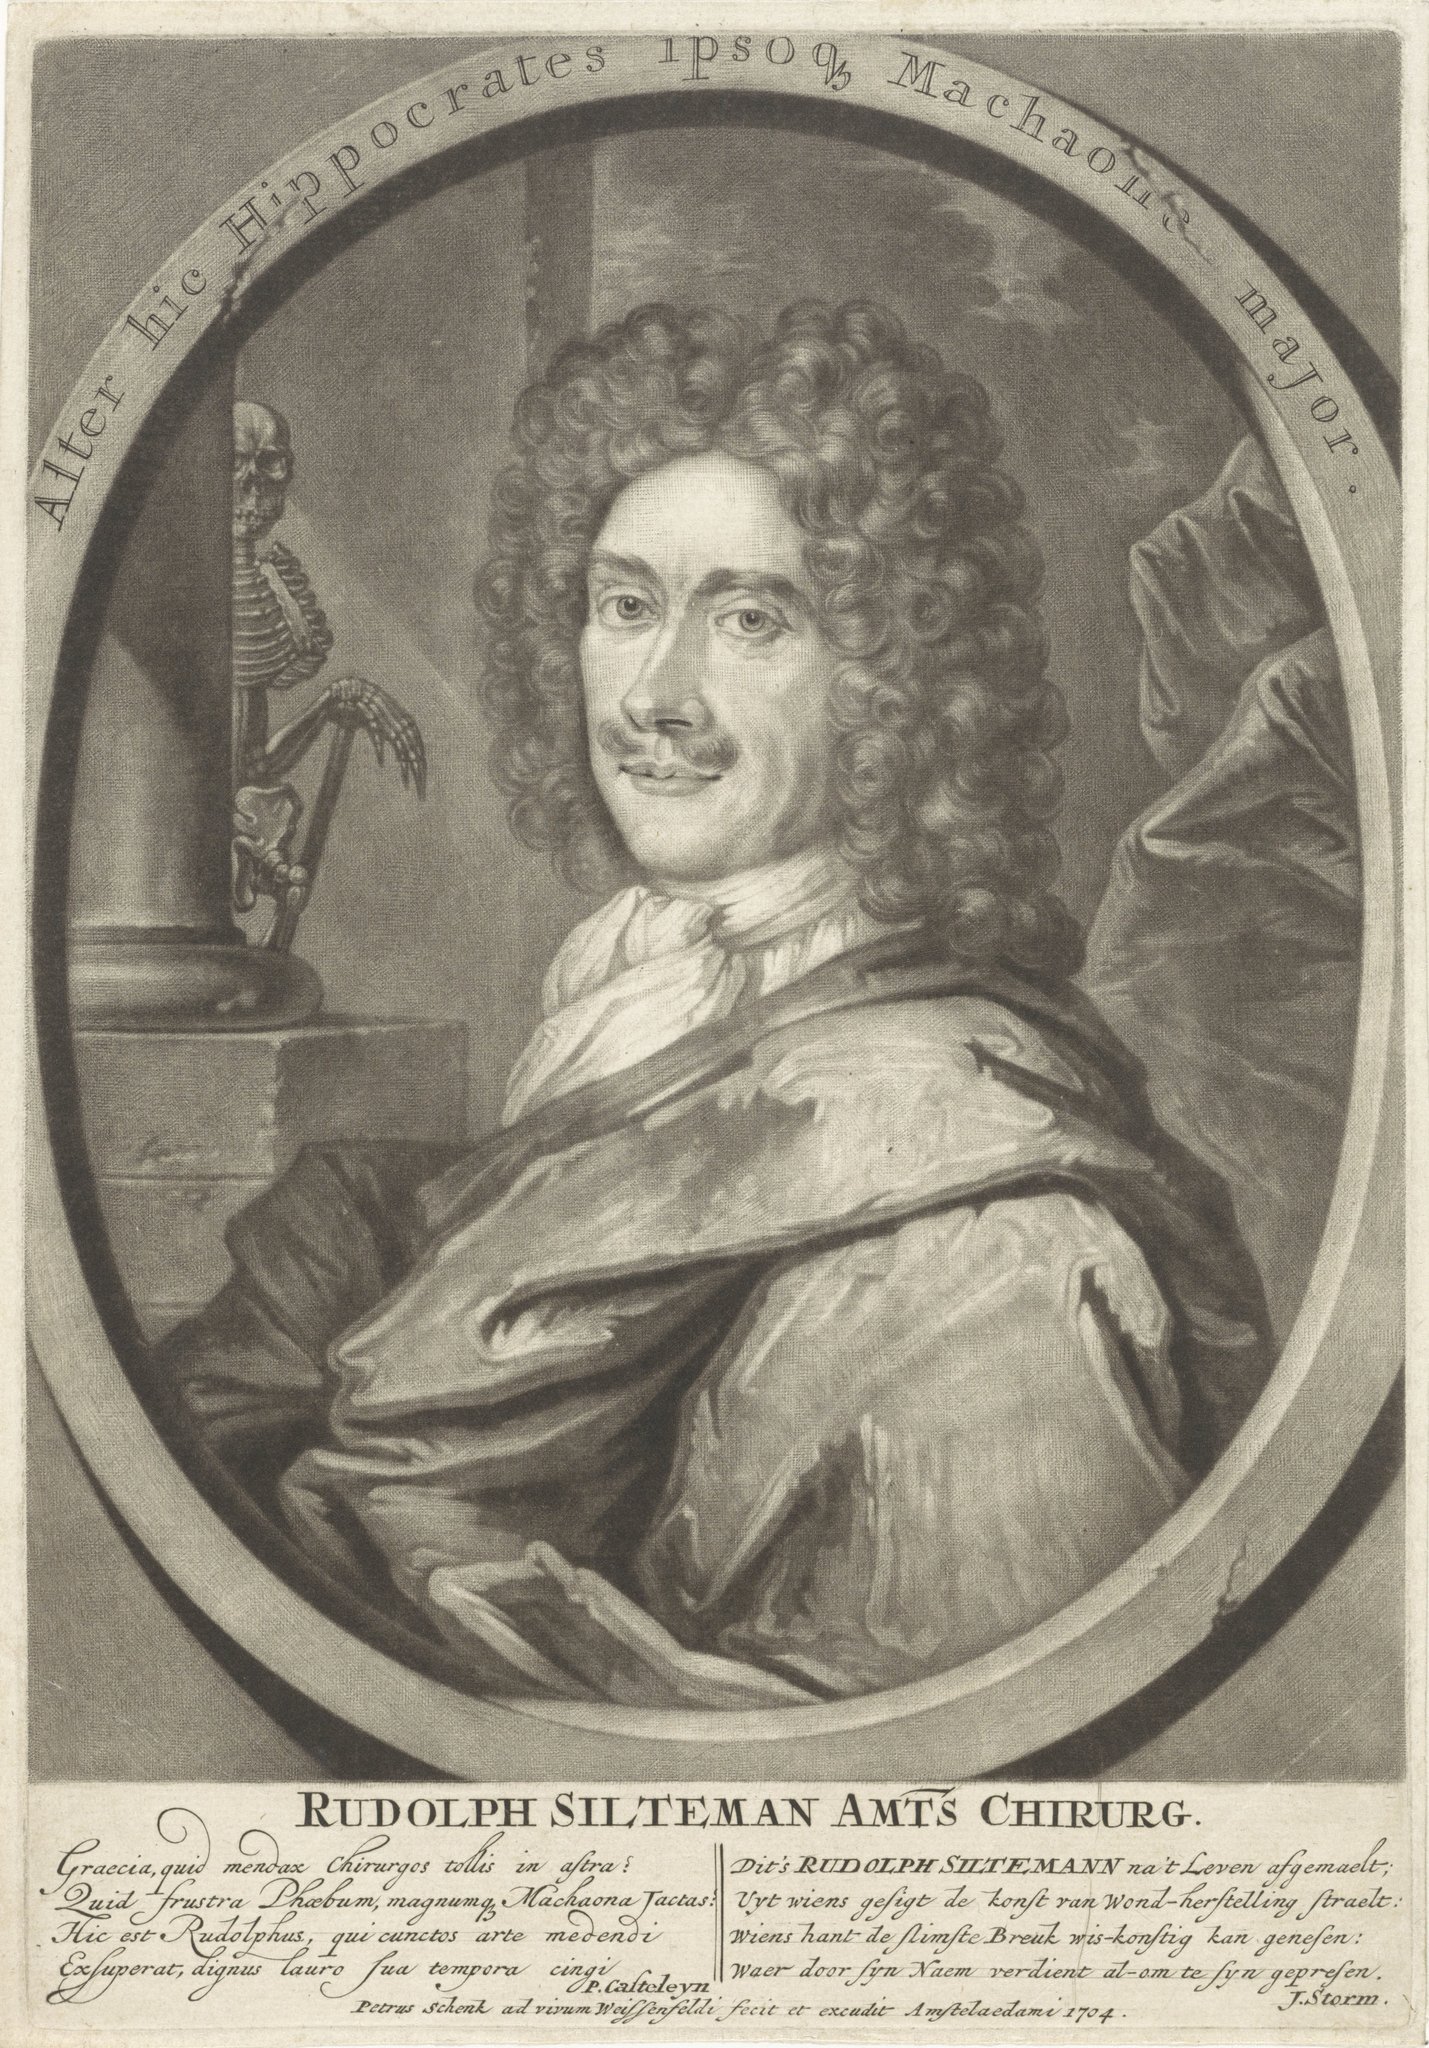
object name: print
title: Portret van Rudolph Silteman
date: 1704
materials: paper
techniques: engraving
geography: amsterdam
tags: (human) skeleton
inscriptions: collector's mark: Lugt 2228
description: De chirurg Rudolph Silteman. Op de achtergrond een zuil en een skelet.